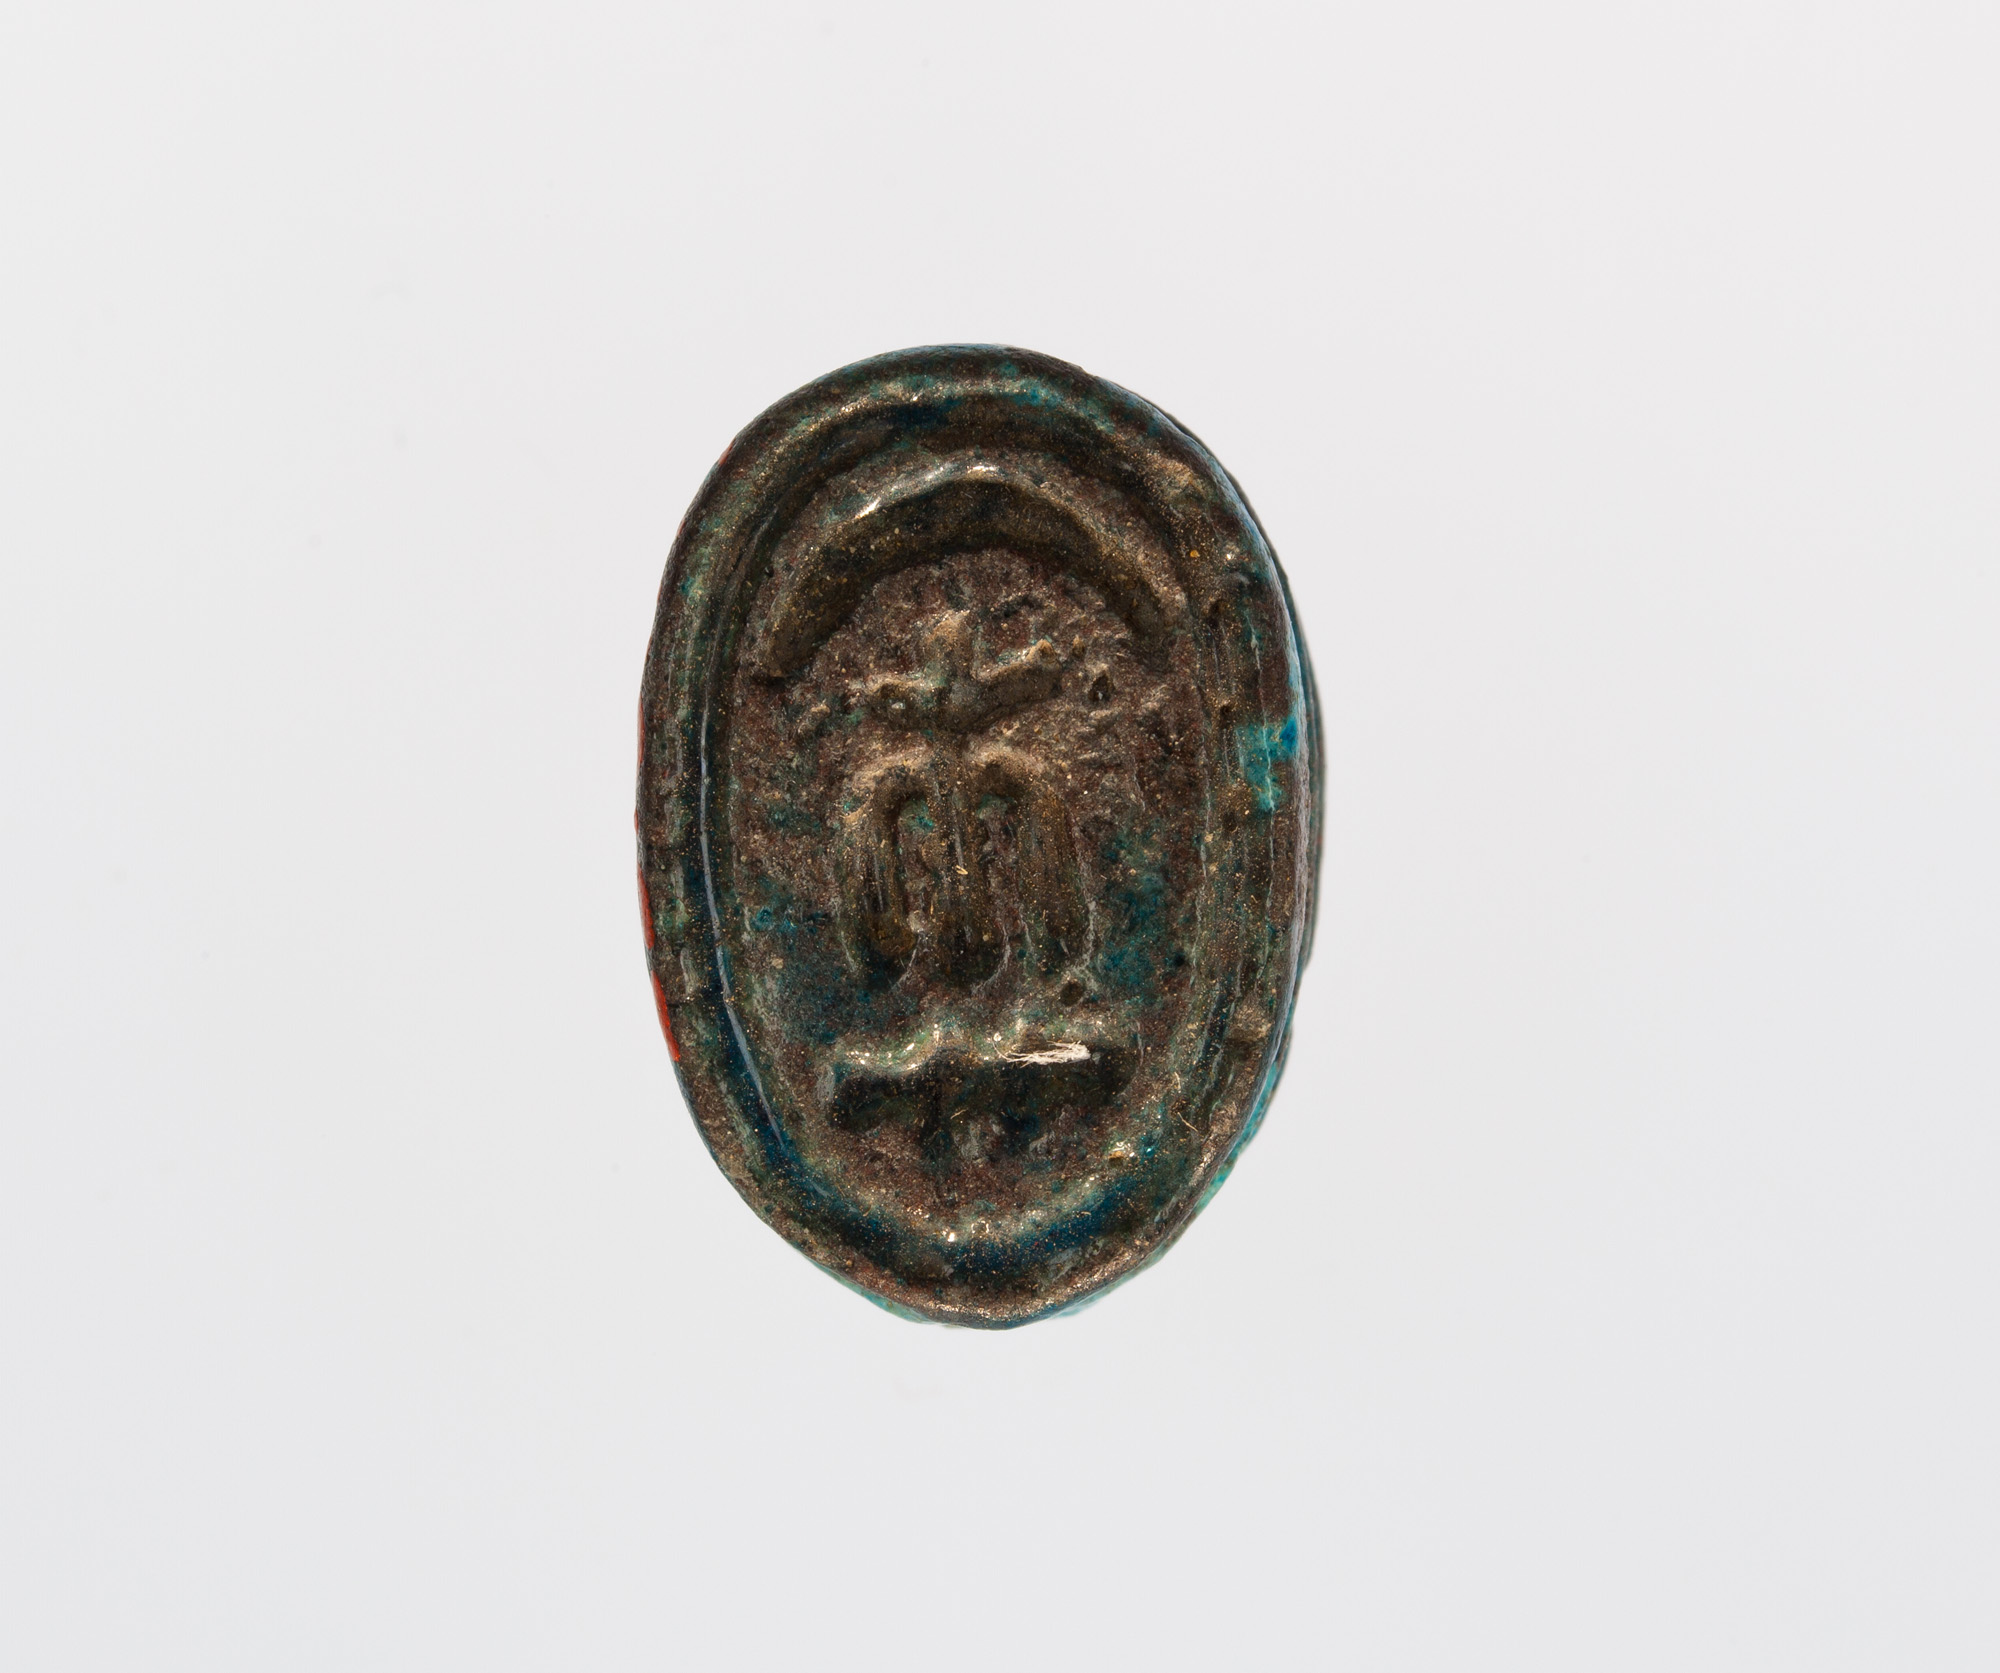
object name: scarab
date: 1479-1458 BCE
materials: faience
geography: egypt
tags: scarabs